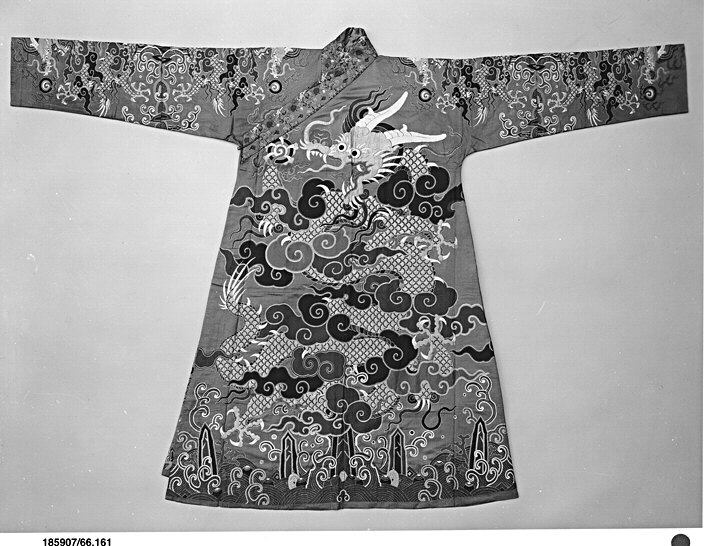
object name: robe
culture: tibetan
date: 1900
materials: textile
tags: dragons